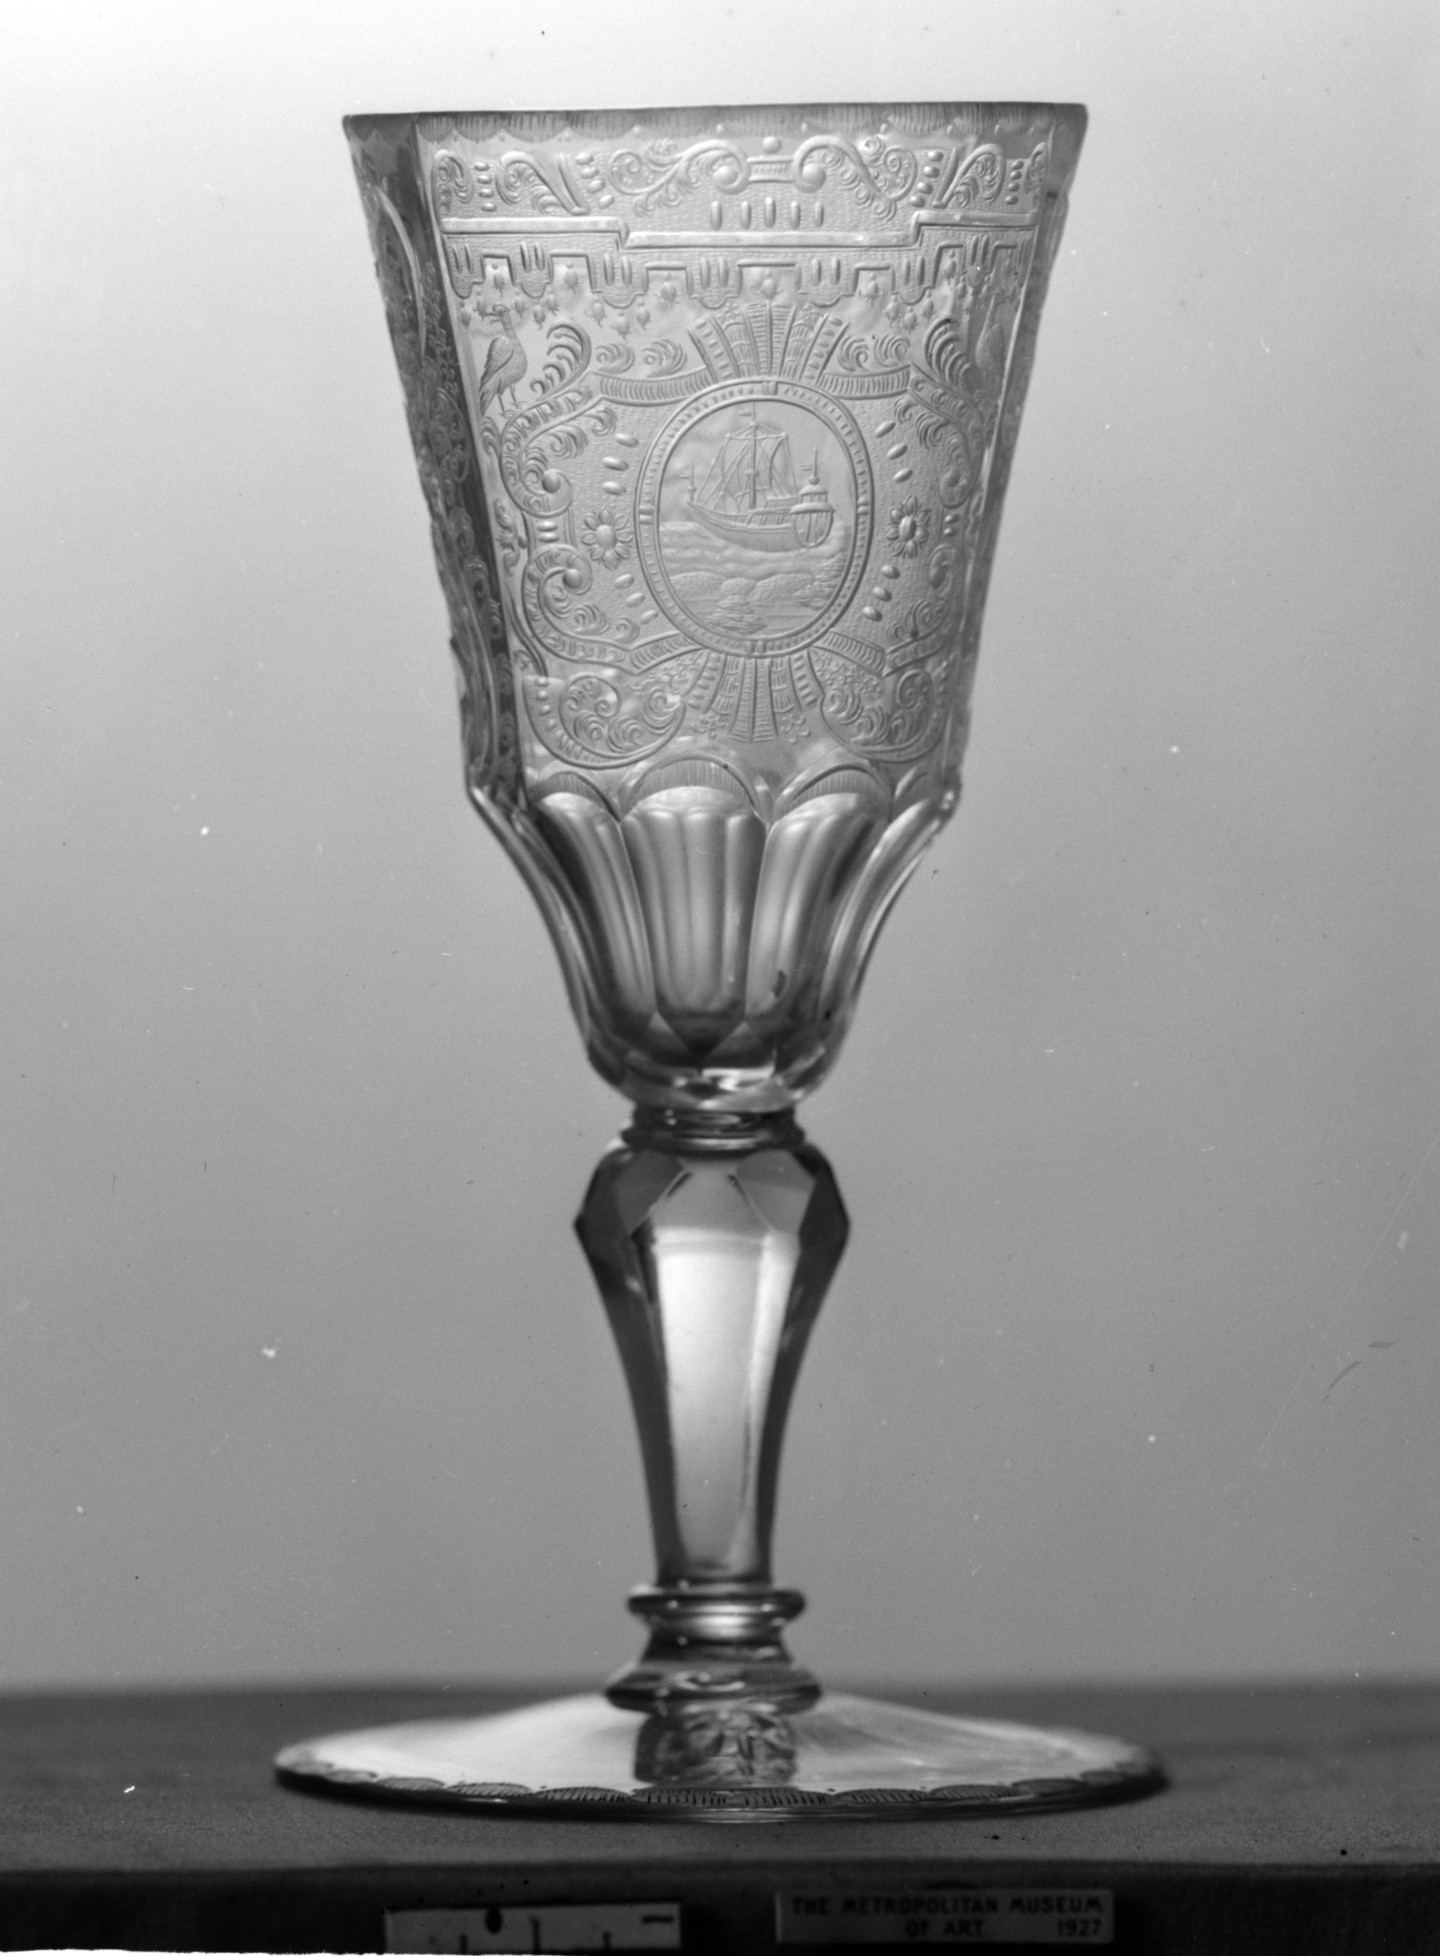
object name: wineglass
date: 1740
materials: glass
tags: ships